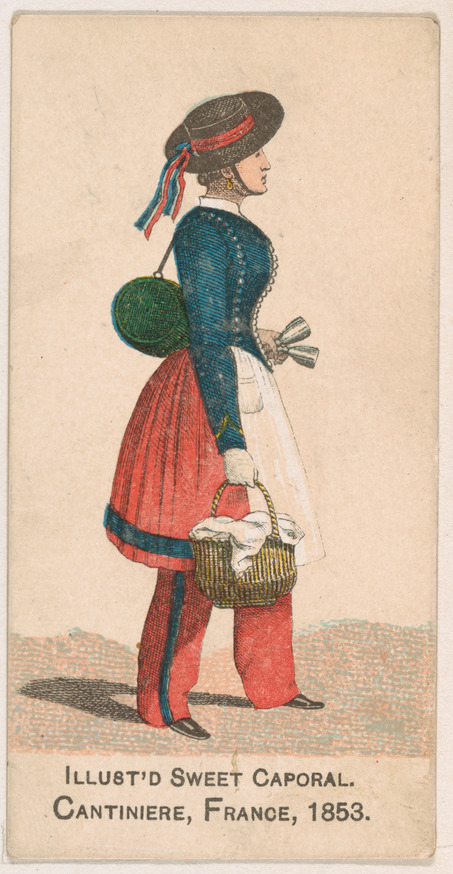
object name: print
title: Cantiniere, France, 1853, from the Military Series (N224) issued by Kinney Tobacco Company to promote Sweet Caporal Cigarettes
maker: kinney brothers tobacco company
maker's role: publisher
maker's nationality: american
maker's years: 1869-2011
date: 1888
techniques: color lithograph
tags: military,profiles,women